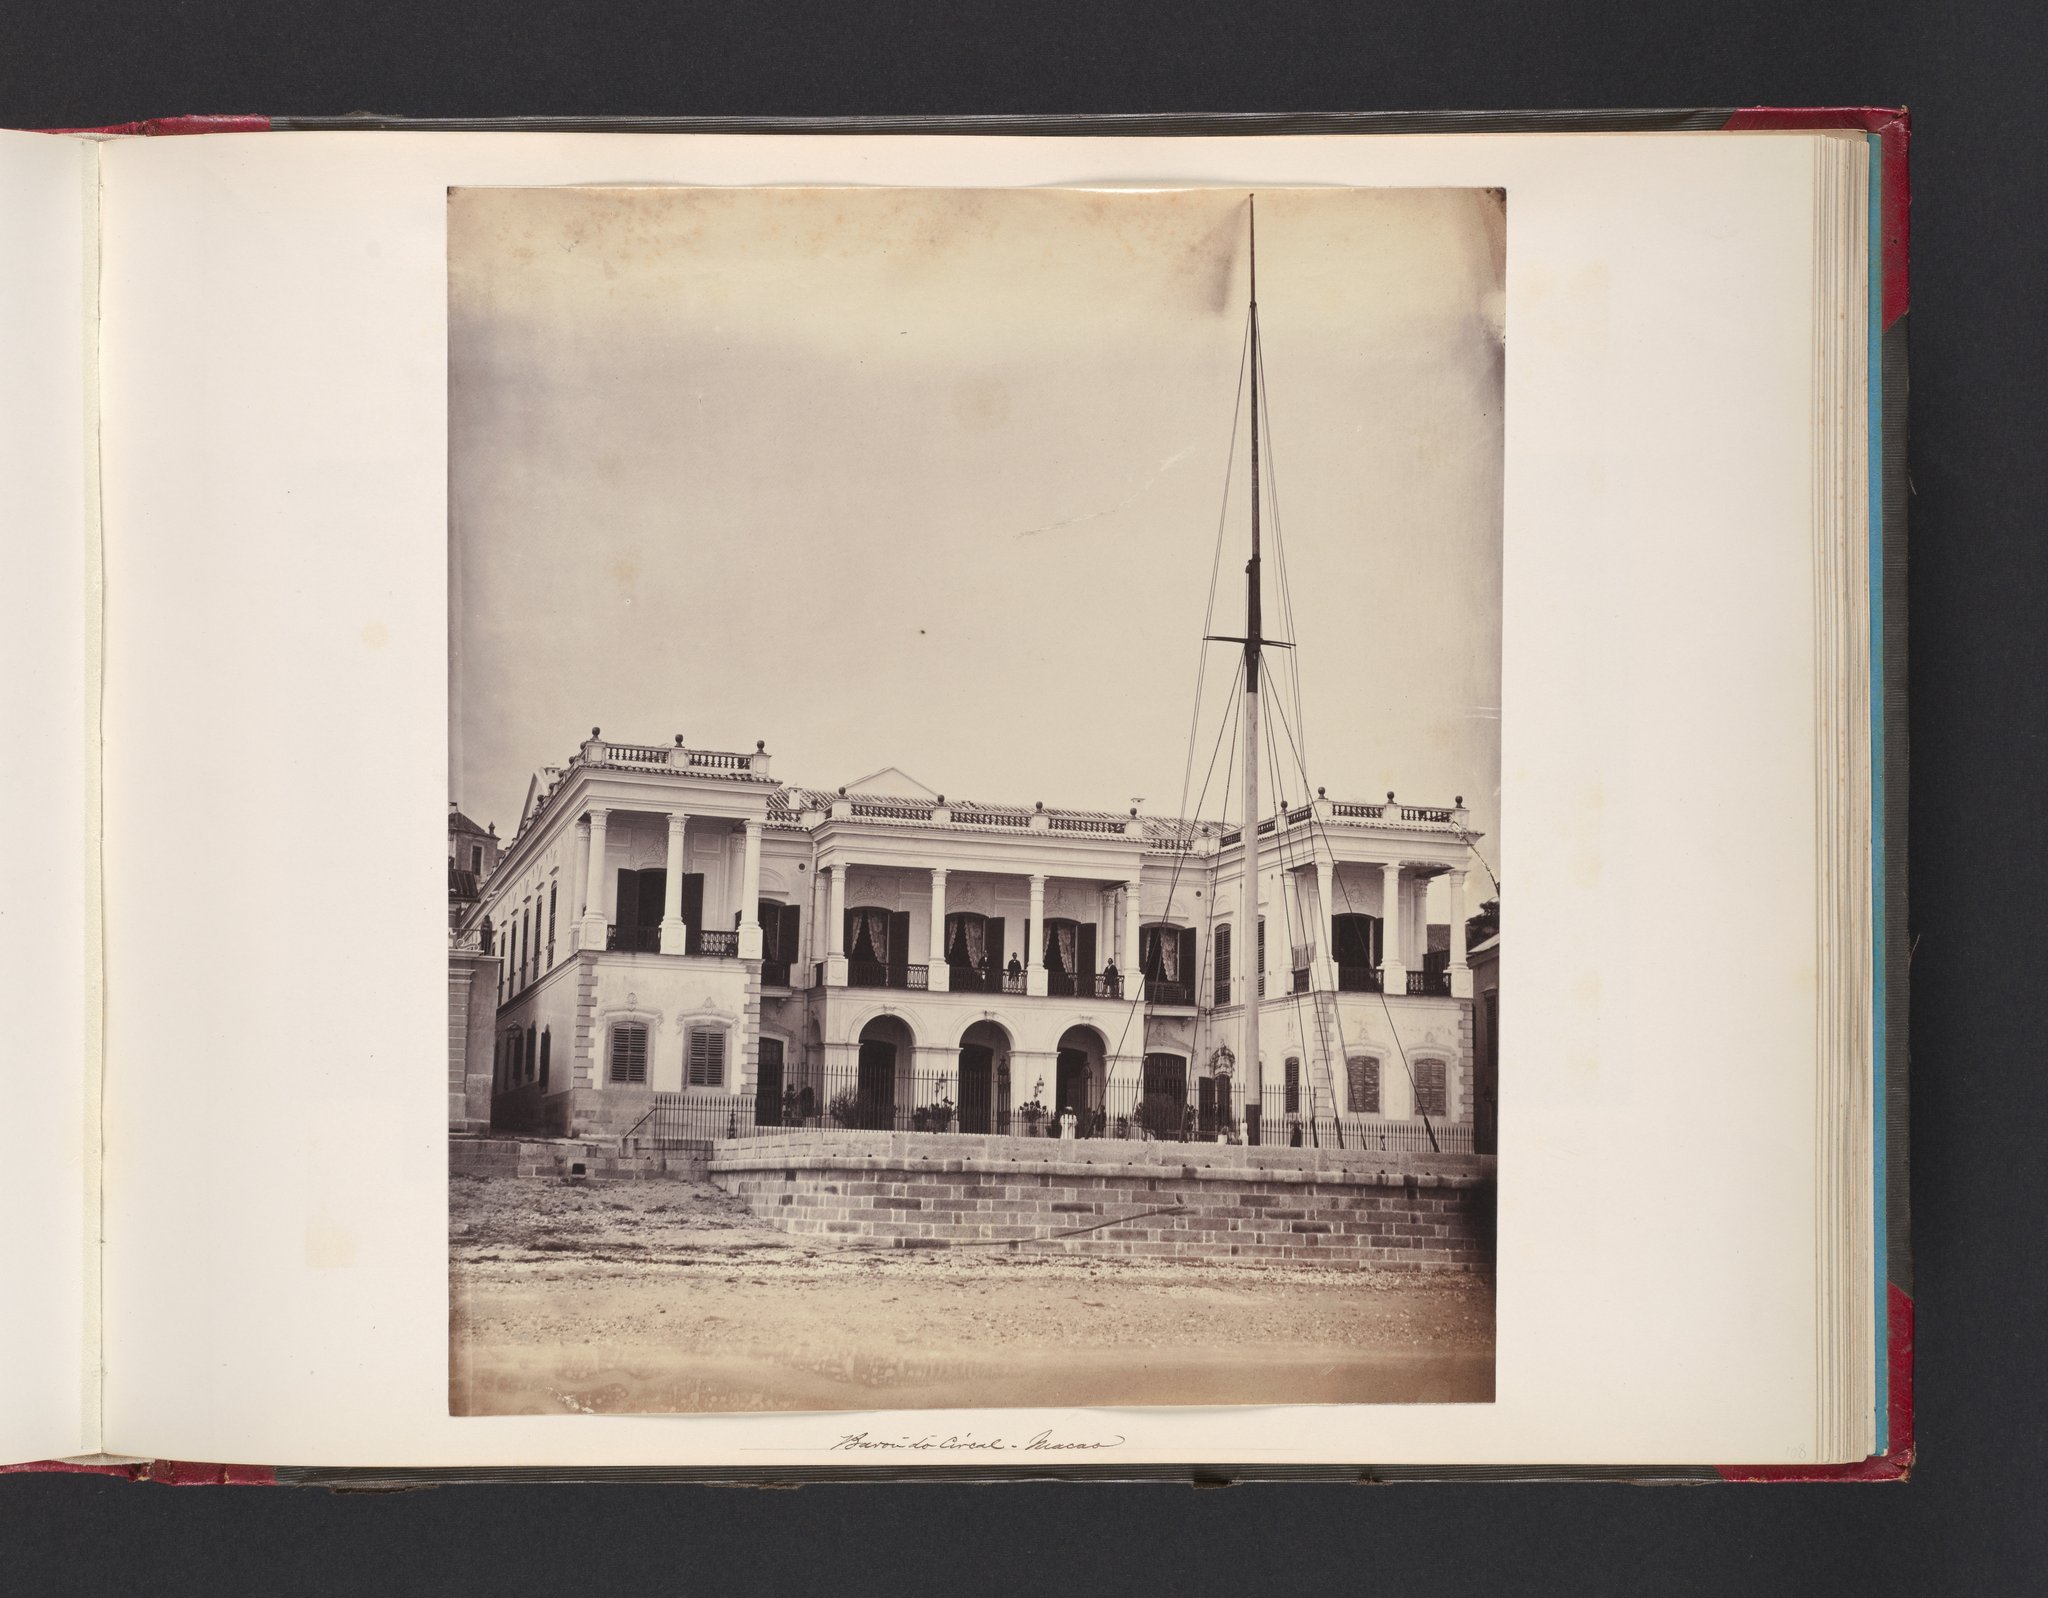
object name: photograph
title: Barou do Circal. Macao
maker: john thomson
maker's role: artist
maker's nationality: british, scottish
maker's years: 1837-1921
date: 1865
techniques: albumen silver print, glass negative